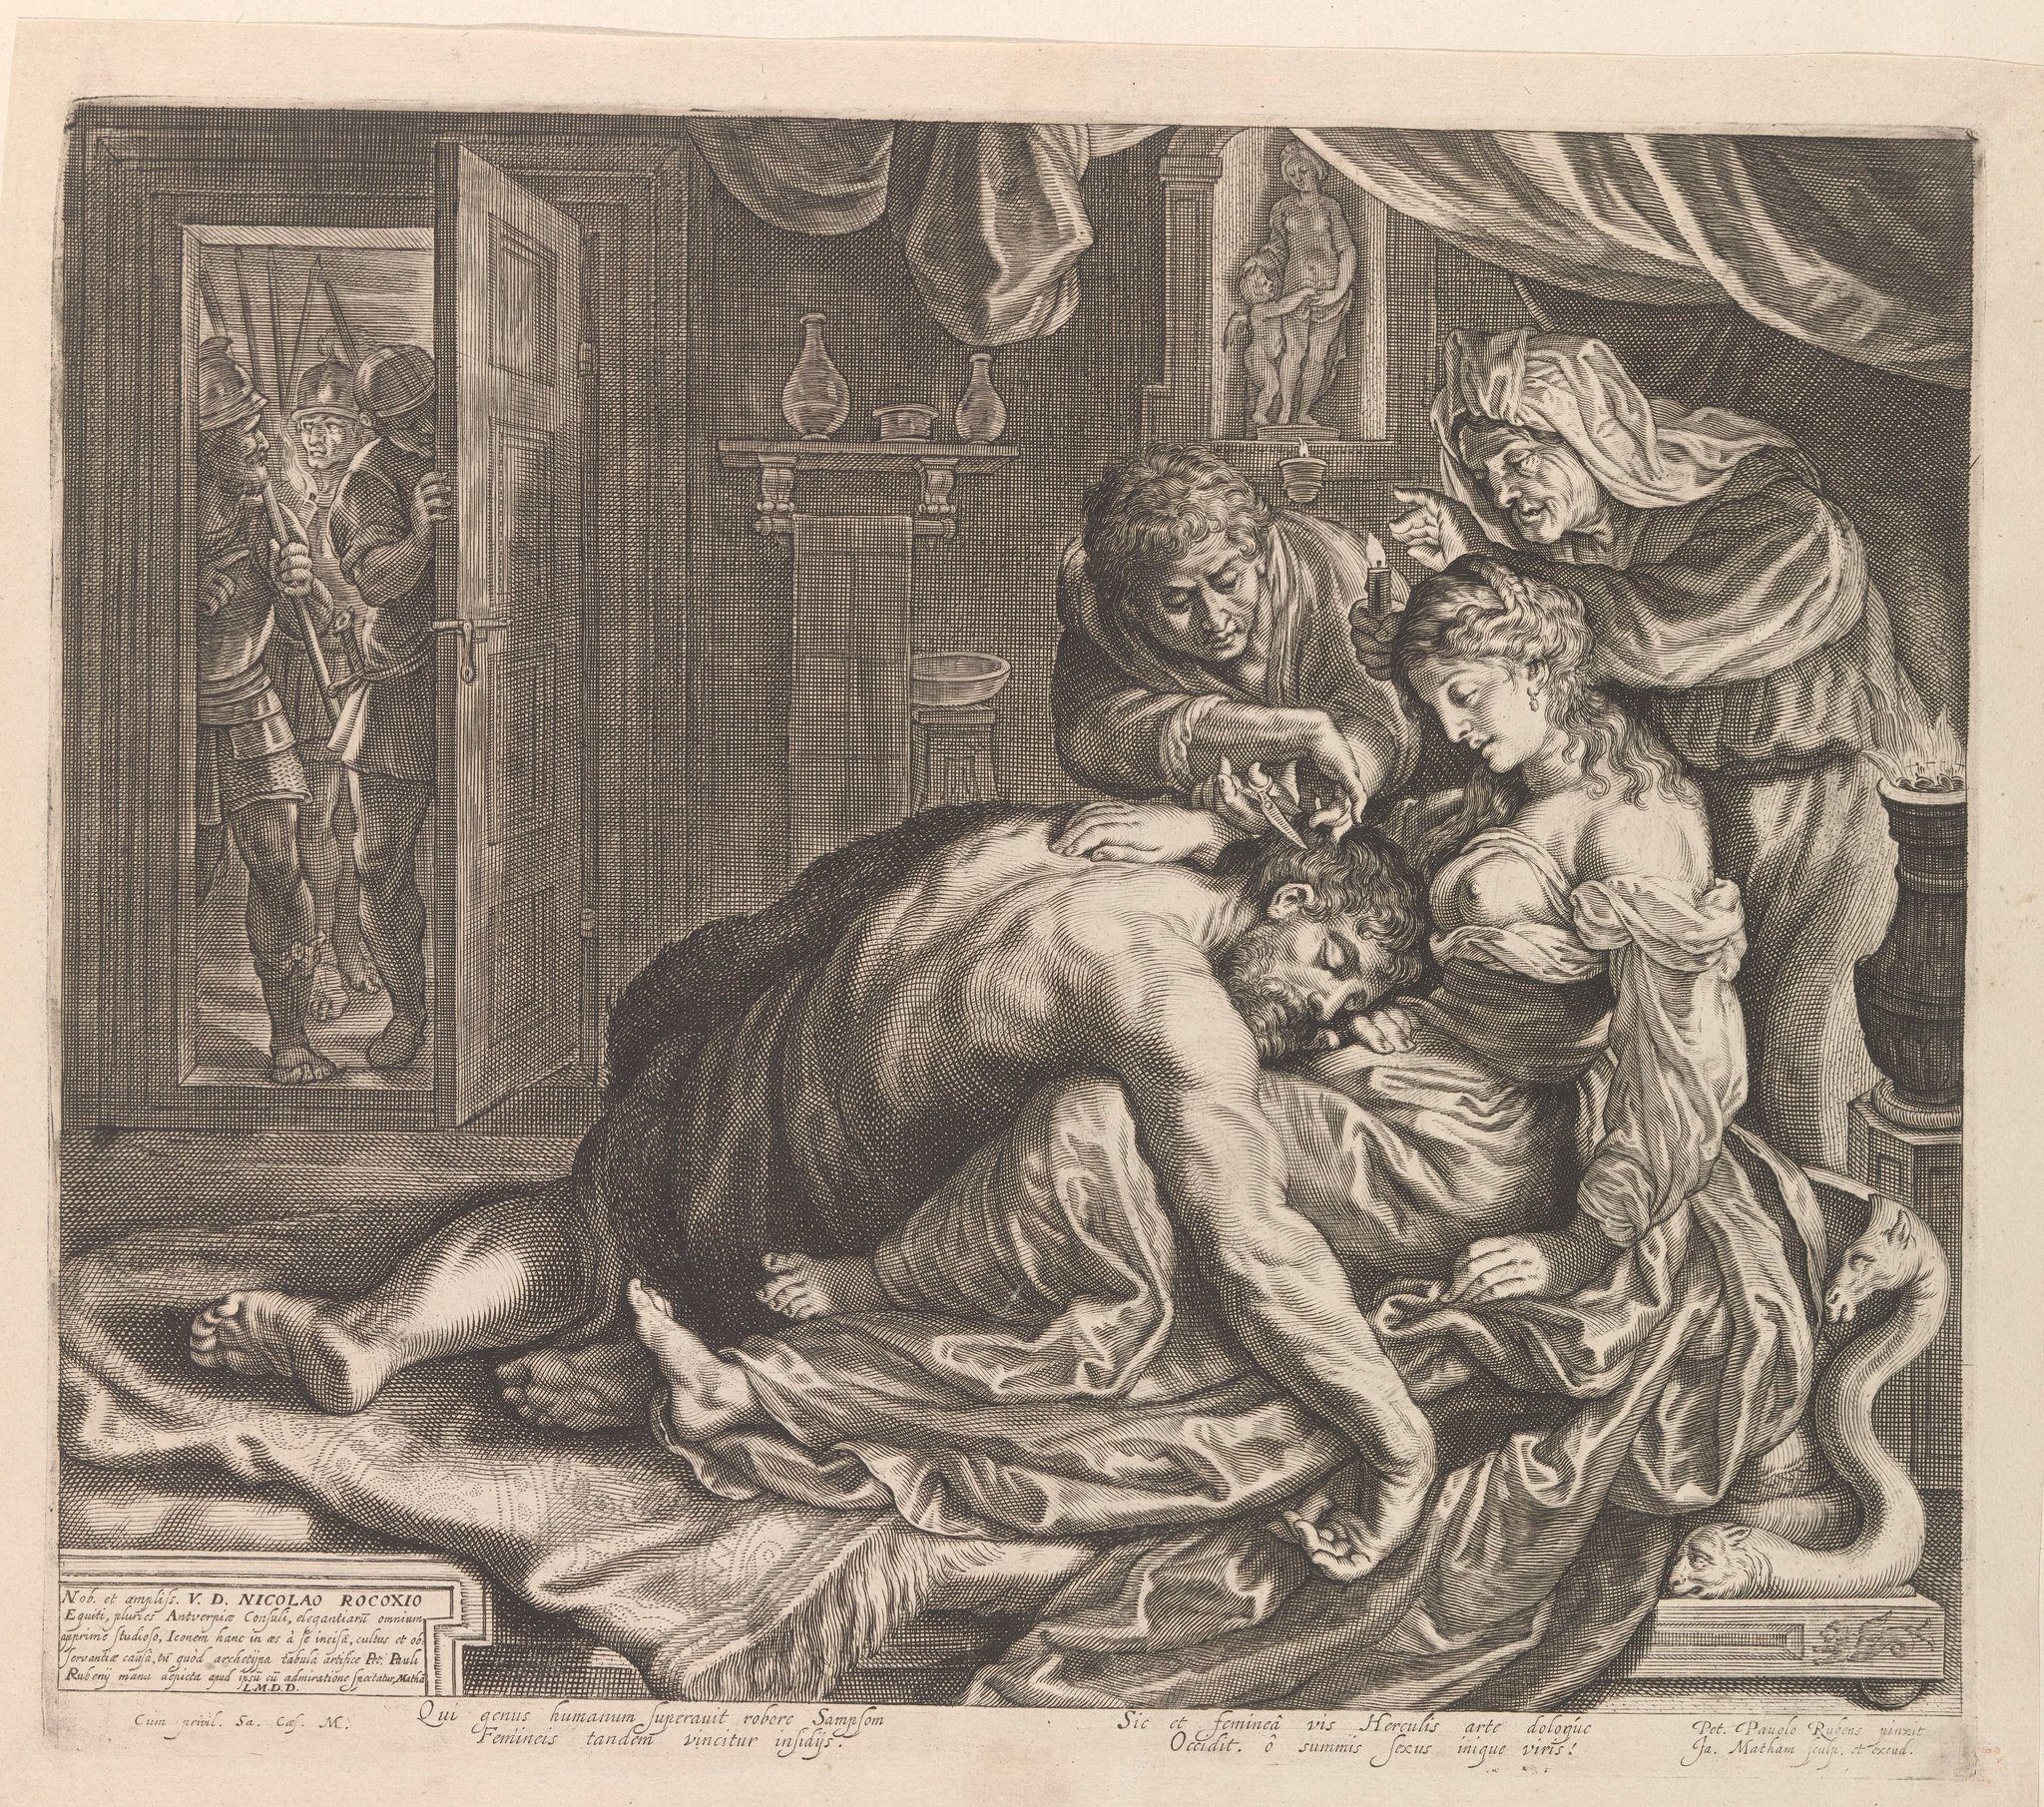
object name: print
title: Simson en Delila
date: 1611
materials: paper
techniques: engraving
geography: antwerp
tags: story of samson and delilah (judges 16:4-21)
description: De haren van Simson worden geknipt door een Filistijn, terwijl hij in Delila's schoot ligt te slapen. Een oude vrouw schijnt bij met een kaars. Soldaten staan klaar in de deuropening om Simson gevangen te nemen, nadat met zijn haar zijn kracht zal zijn verdwenen. Deze prent maakt deel uit van een album.